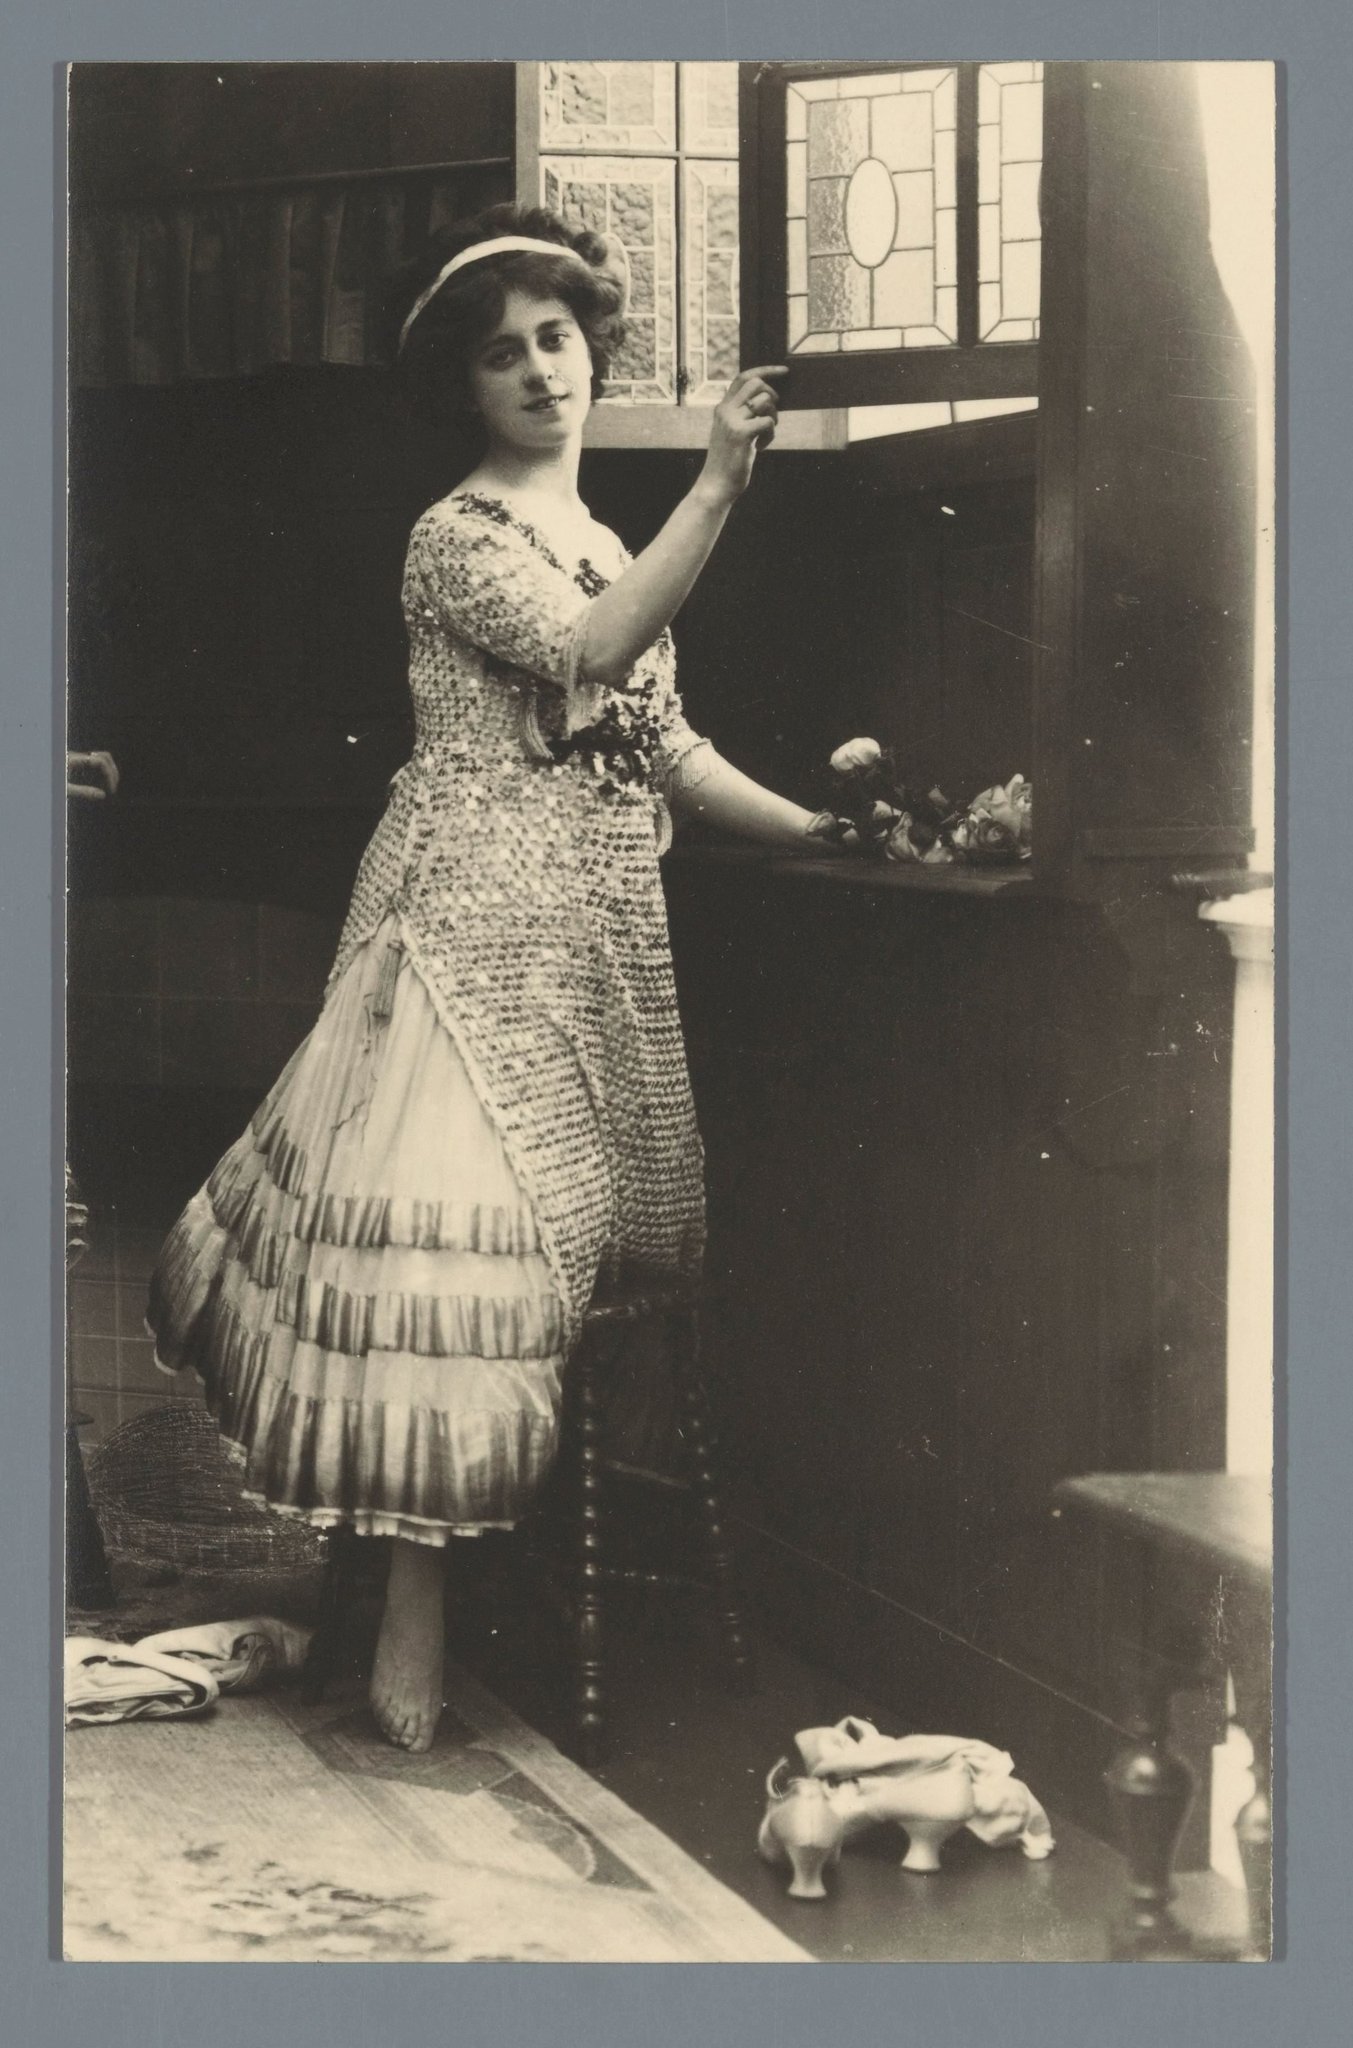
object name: ansichtkaart, prentbriefkaart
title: Portret van een onbekende vrouw naast een open raam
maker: Anonymous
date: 1907-1920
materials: photographic support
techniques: gelatin silver print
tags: adult woman, opening the window, interior ~ representation of a building